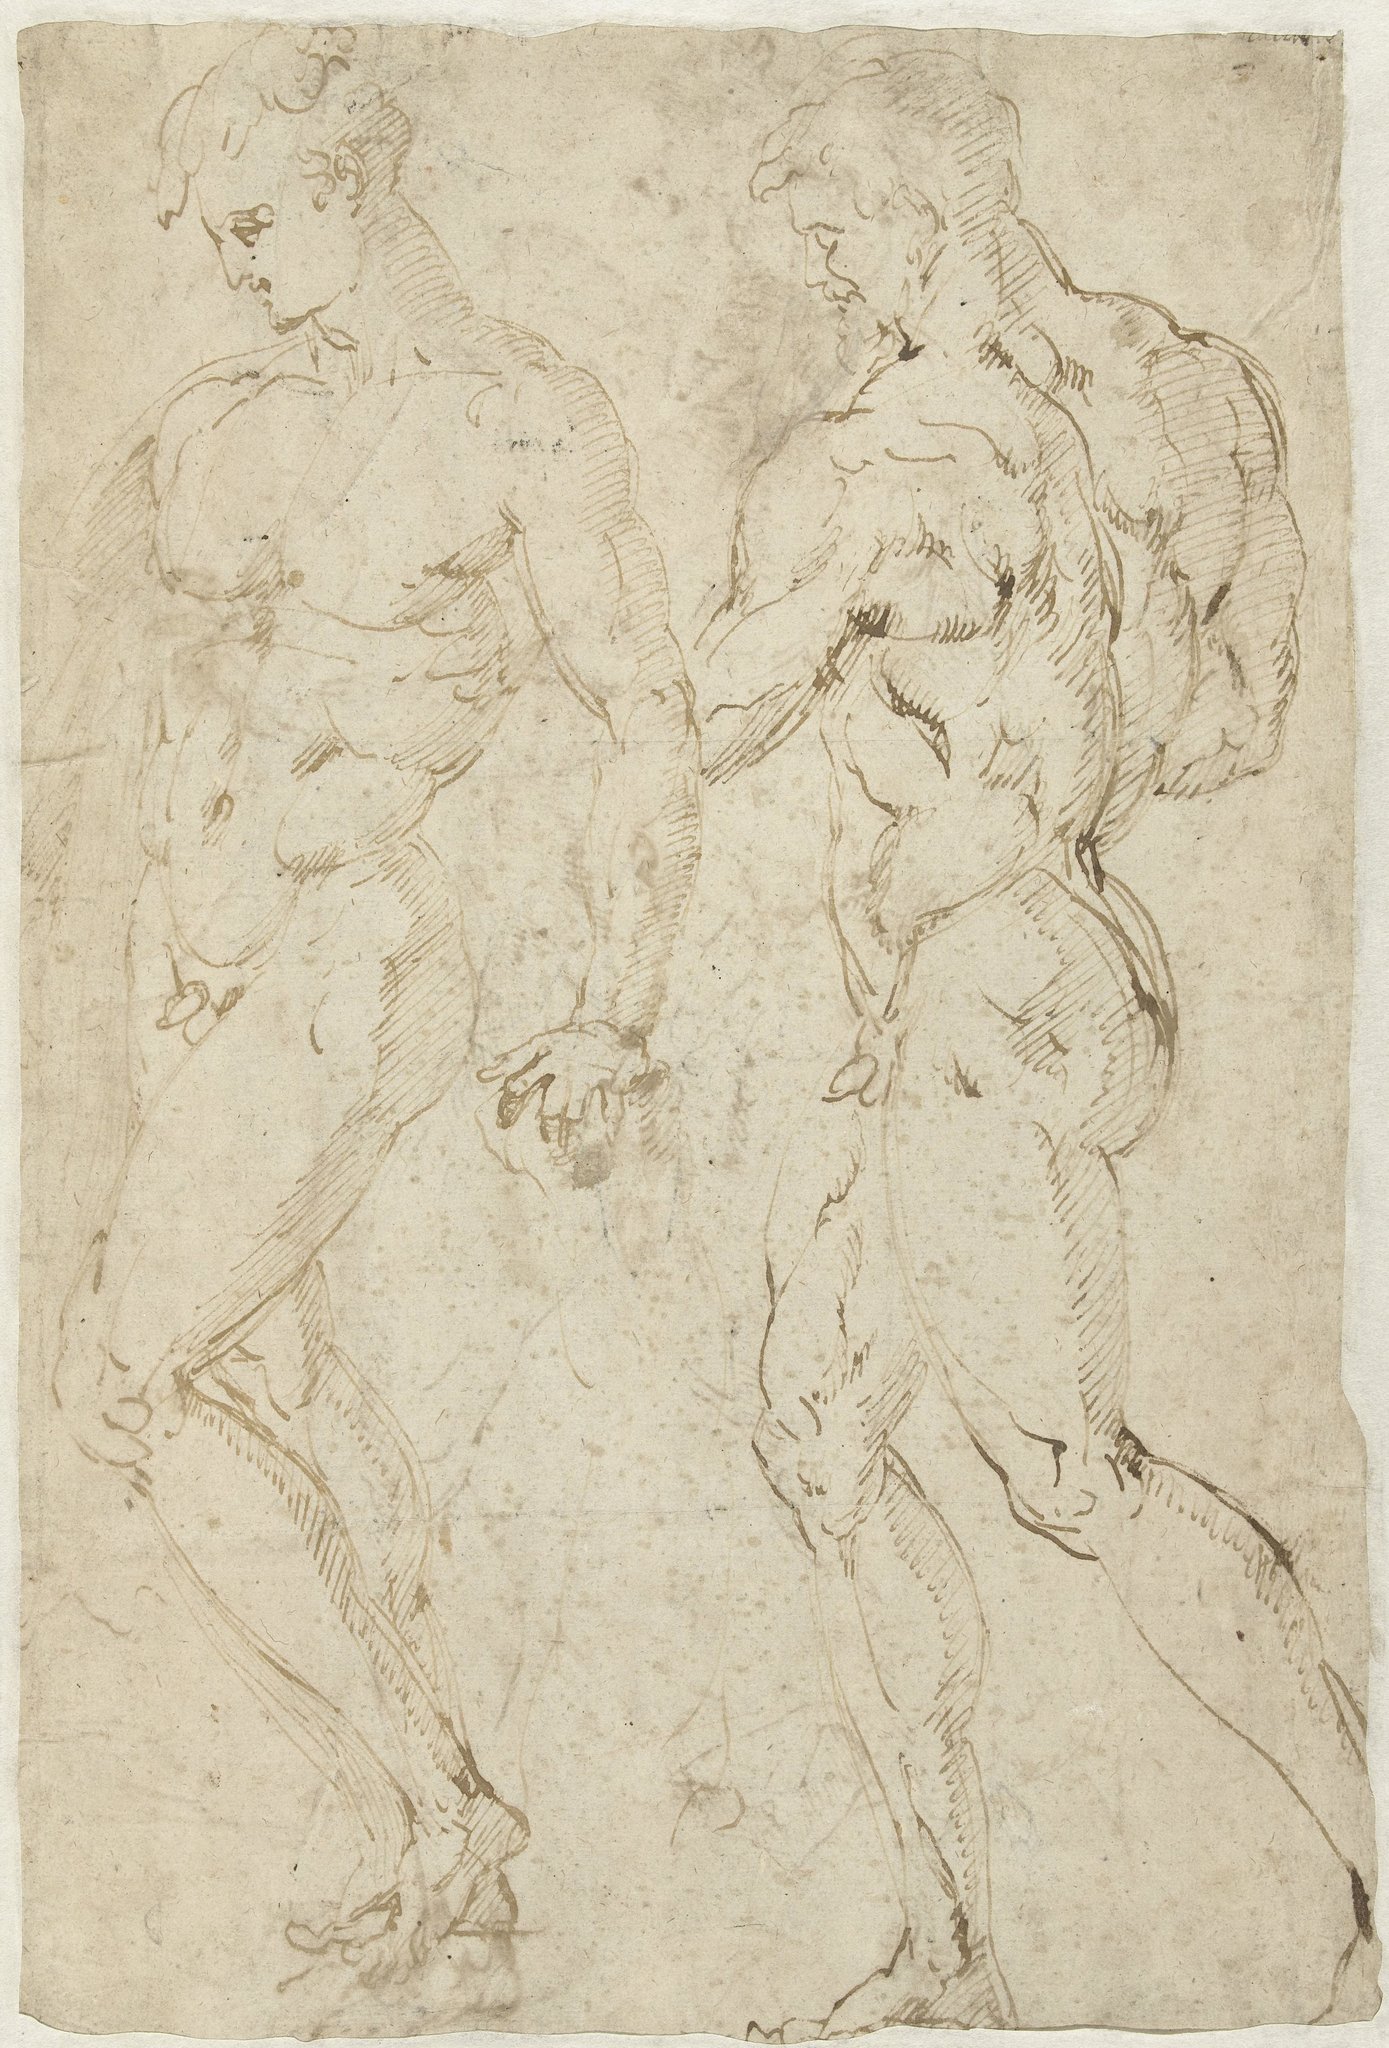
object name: drawing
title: Naakte man in houding van vertwijfeling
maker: Anonymous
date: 1510-1600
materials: ink, paper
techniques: pen